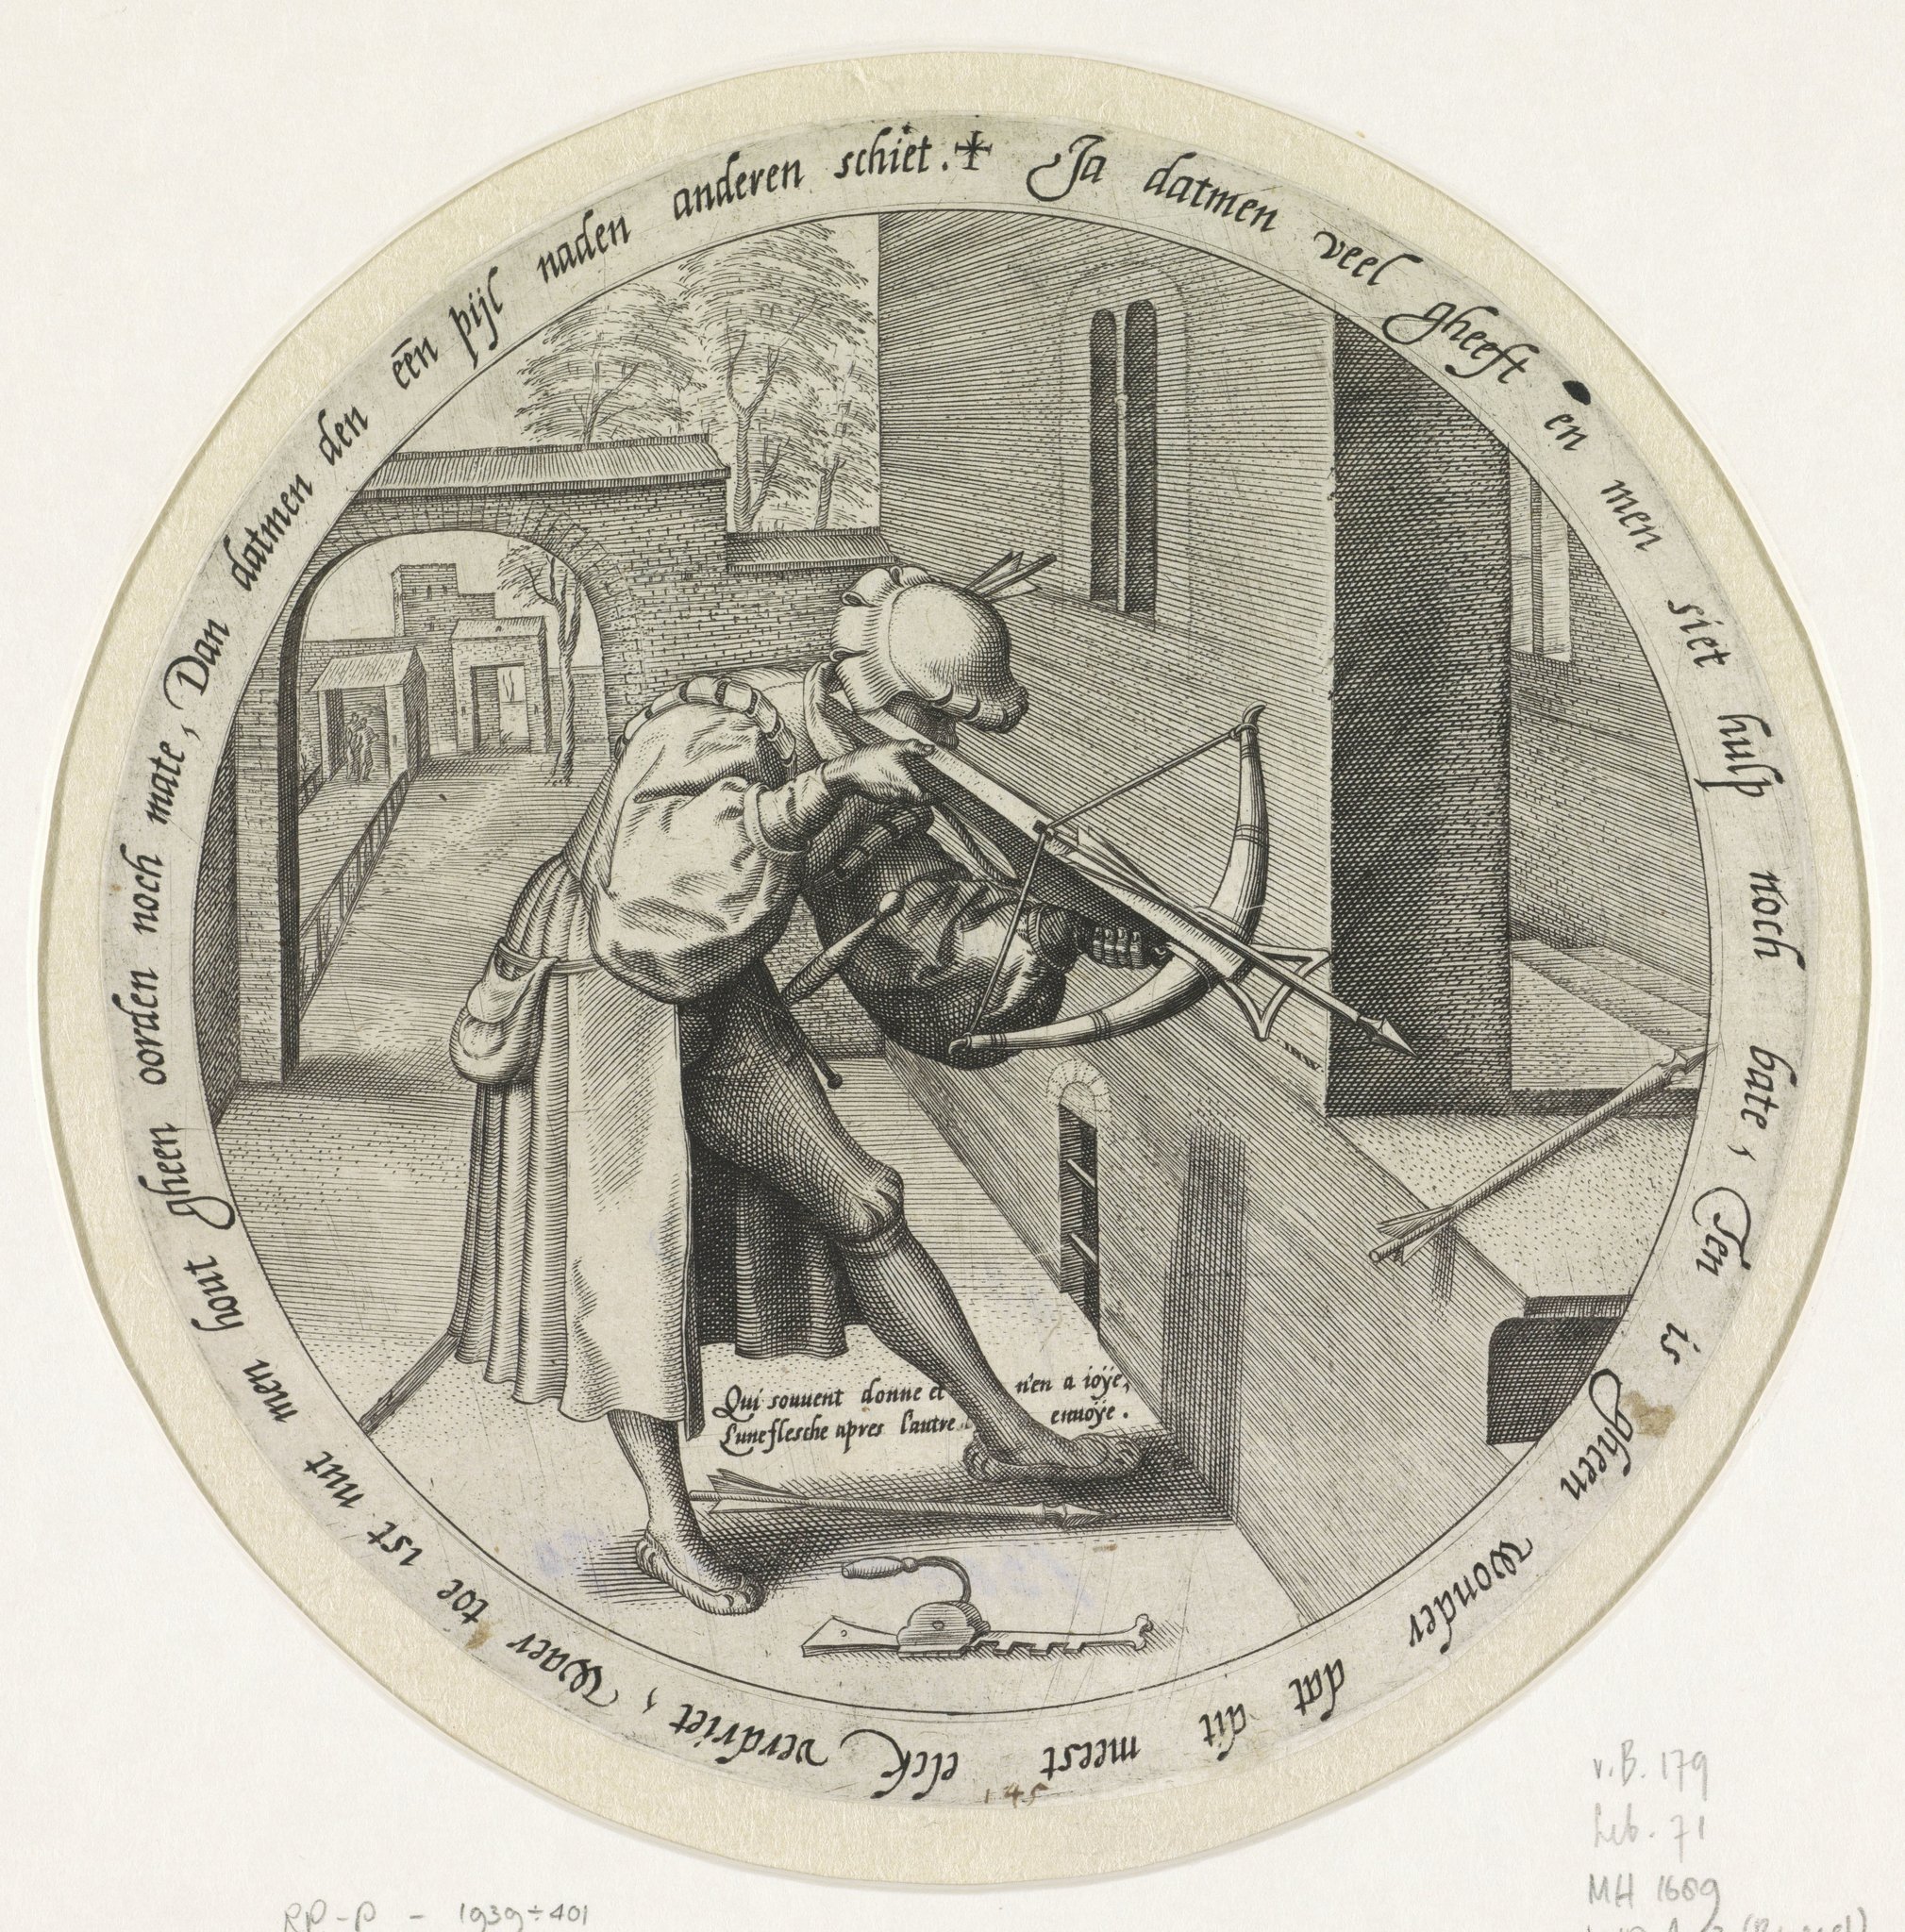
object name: print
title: Boogschutter verspilt zijn pijlen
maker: johannes wierix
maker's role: draughtsman, print maker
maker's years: 1549-1618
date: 1566-1570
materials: paper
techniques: engraving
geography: antwerp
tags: archer's weapons: bow and arrow, proverbs, sayings, etc.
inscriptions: collector's mark: Lugt 2228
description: Een boogschutter schiet al zijn pijlen in een nis in de muur. In het randschrift een toelichting op de voorstelling en op het spreekwoord in het Nederlands.